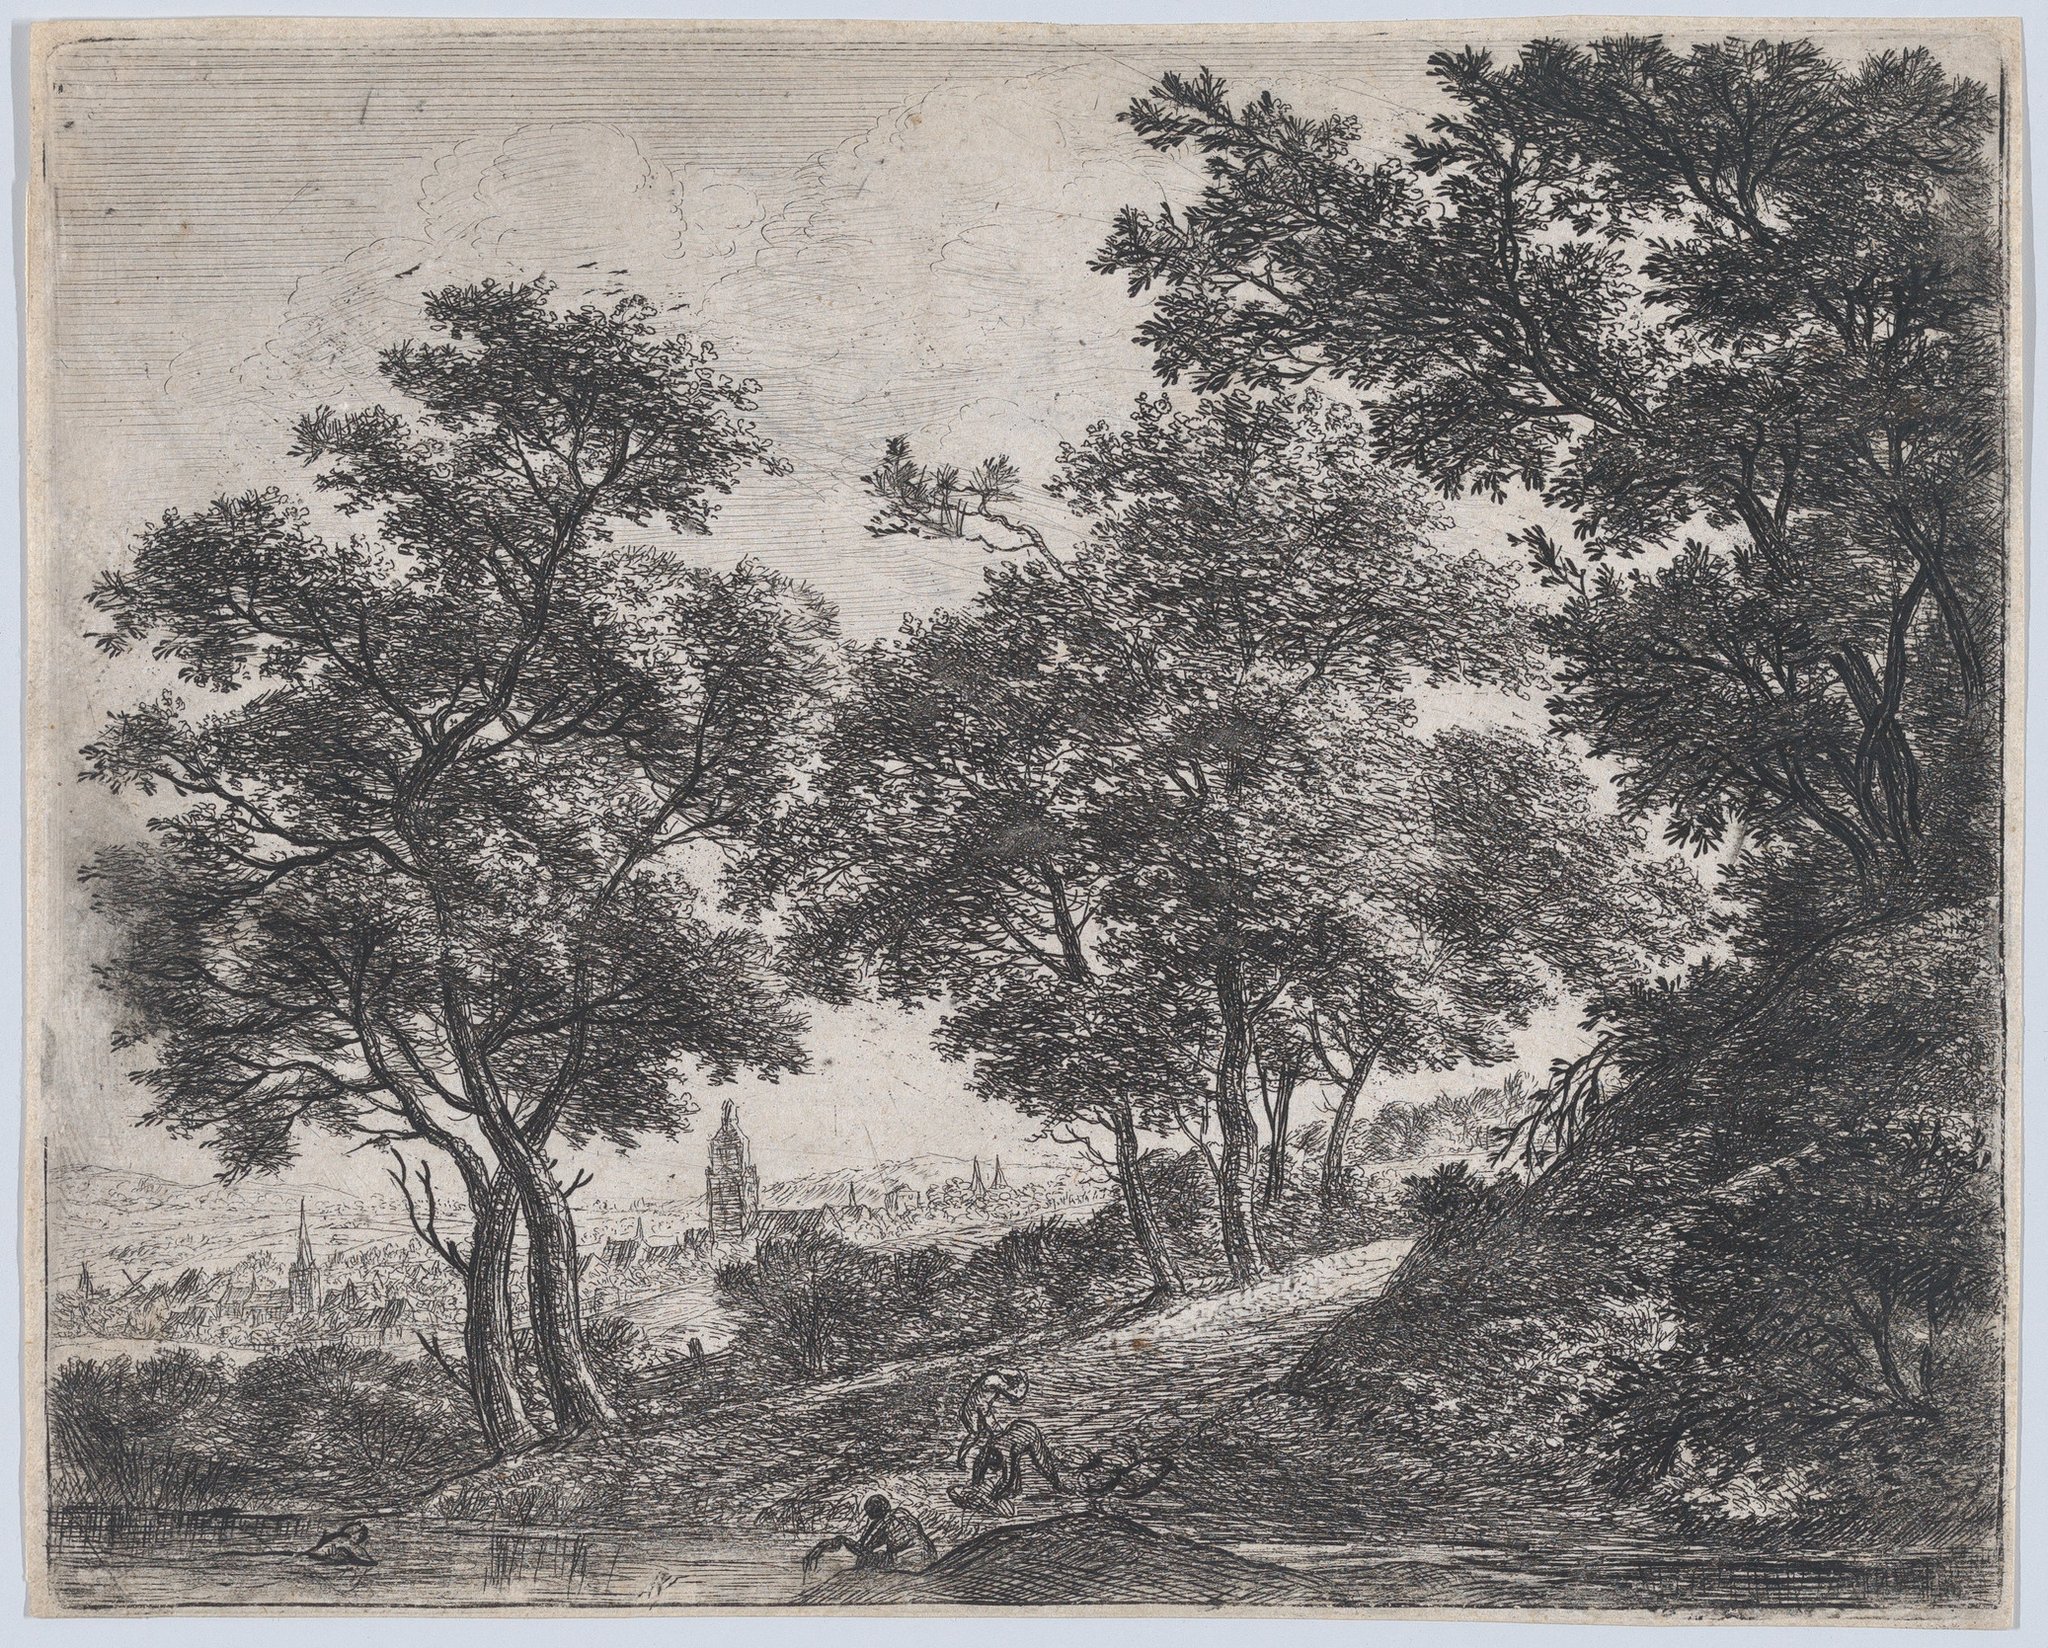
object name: print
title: Bathers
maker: anthonie waterloo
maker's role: artist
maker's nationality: dutch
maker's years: 1609-1690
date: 1601-1700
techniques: etching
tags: landscapes,bathing